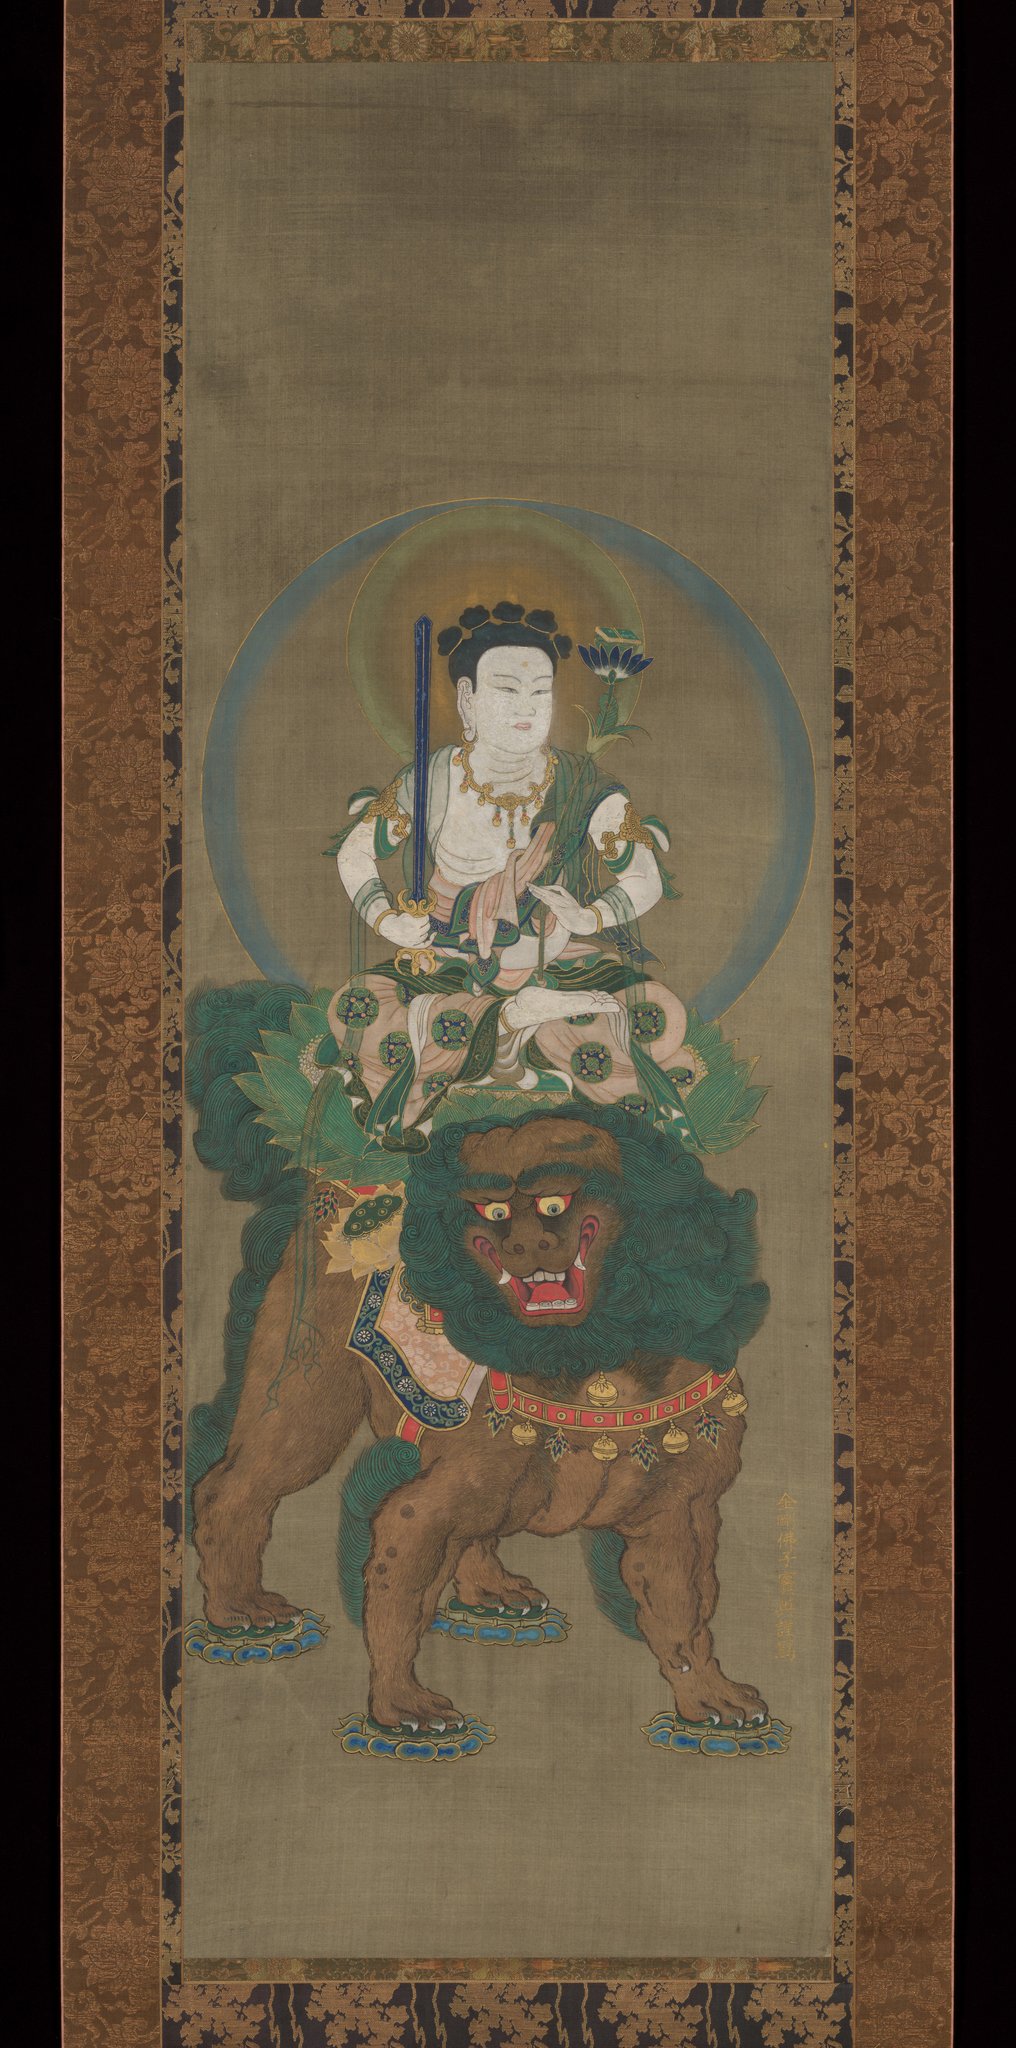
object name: hanging scroll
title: The Bodhisattva Five-Topknot Monju (Manjushri) (Gokei Monju Bosatsu zō)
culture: japanese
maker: unidentified artist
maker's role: artist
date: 1701-1800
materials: gold, ink, pigment, silk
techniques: cutting, kirikane